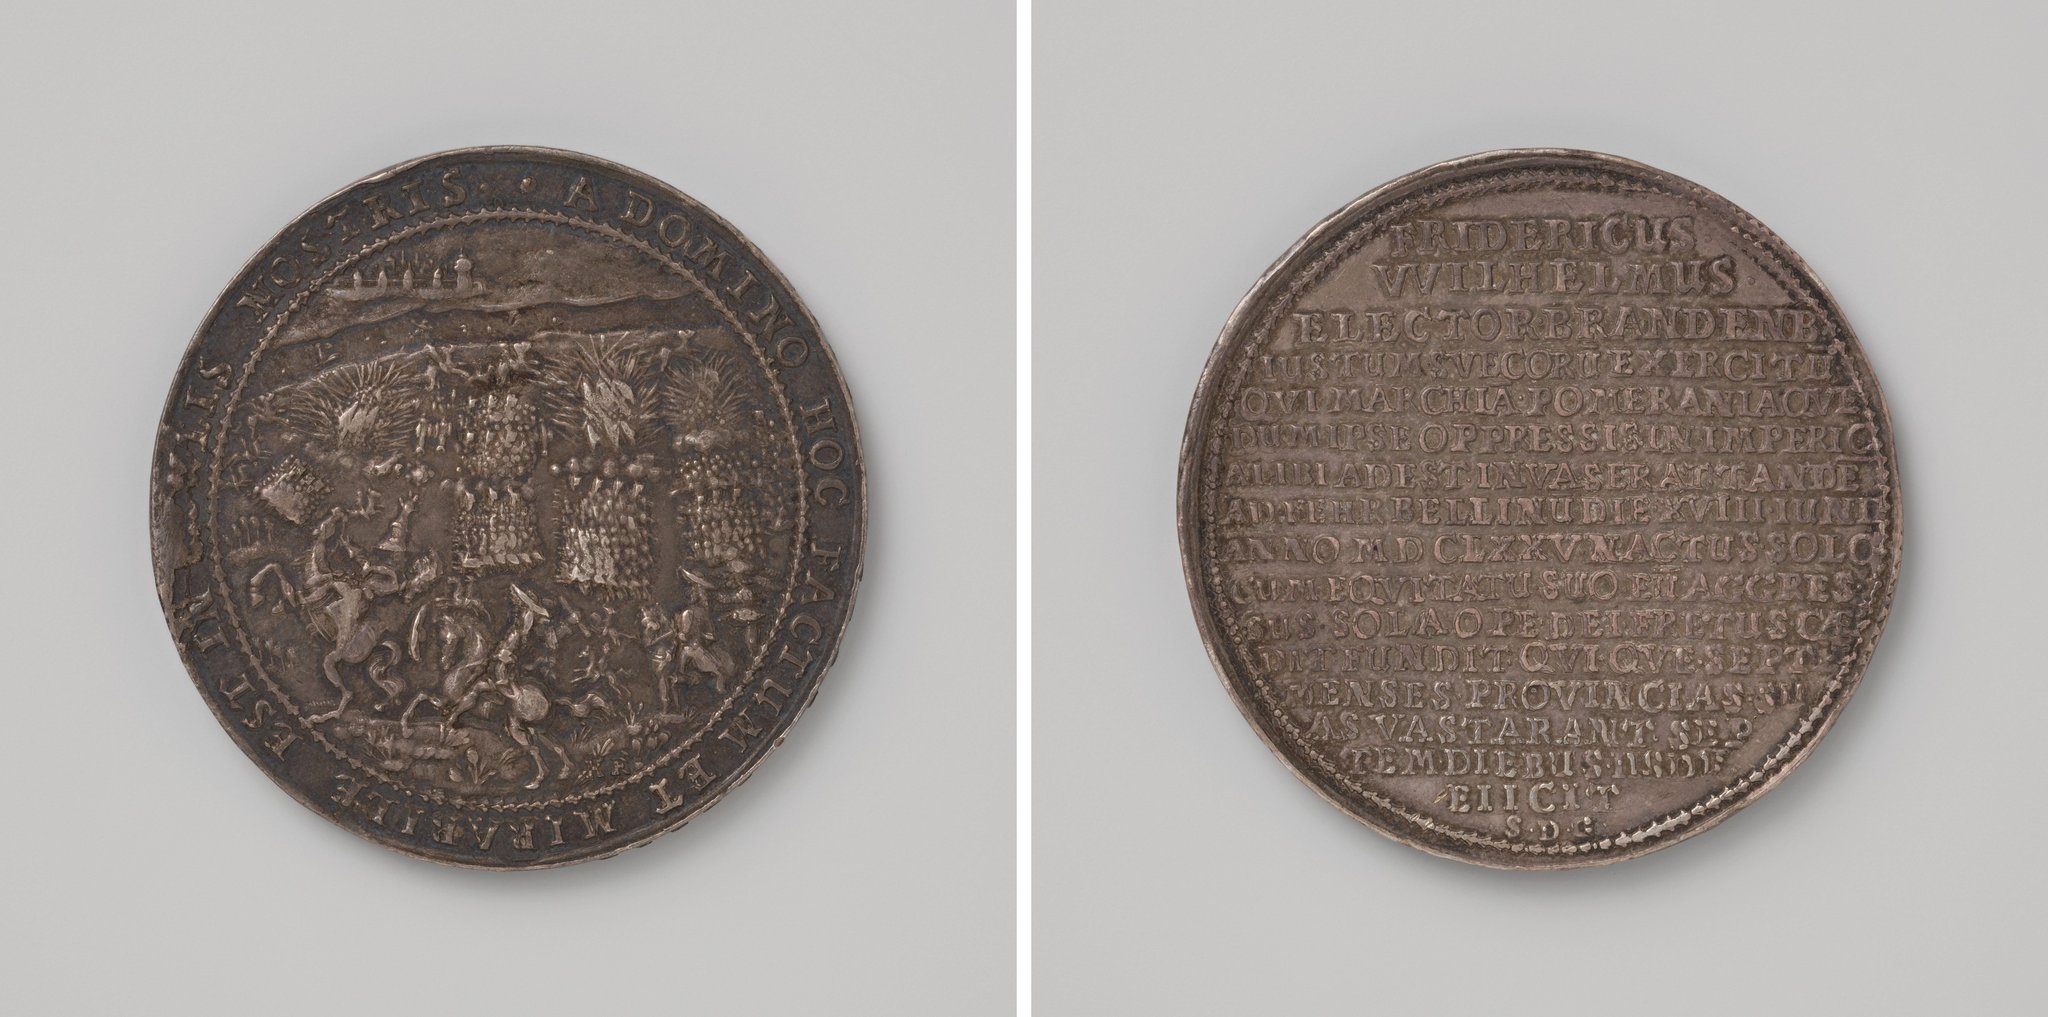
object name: history medal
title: Overwinning op de Zweden bij Ferbellin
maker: johann höhn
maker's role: medailleur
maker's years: 1637-1693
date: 1675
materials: silver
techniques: striking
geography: gdansk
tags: berlin, frederik willem van brandenburg (i)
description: Zilveren penning. Voorzijde: afbeelding van slag binnen omschrift. Keerzijde: opschrift.